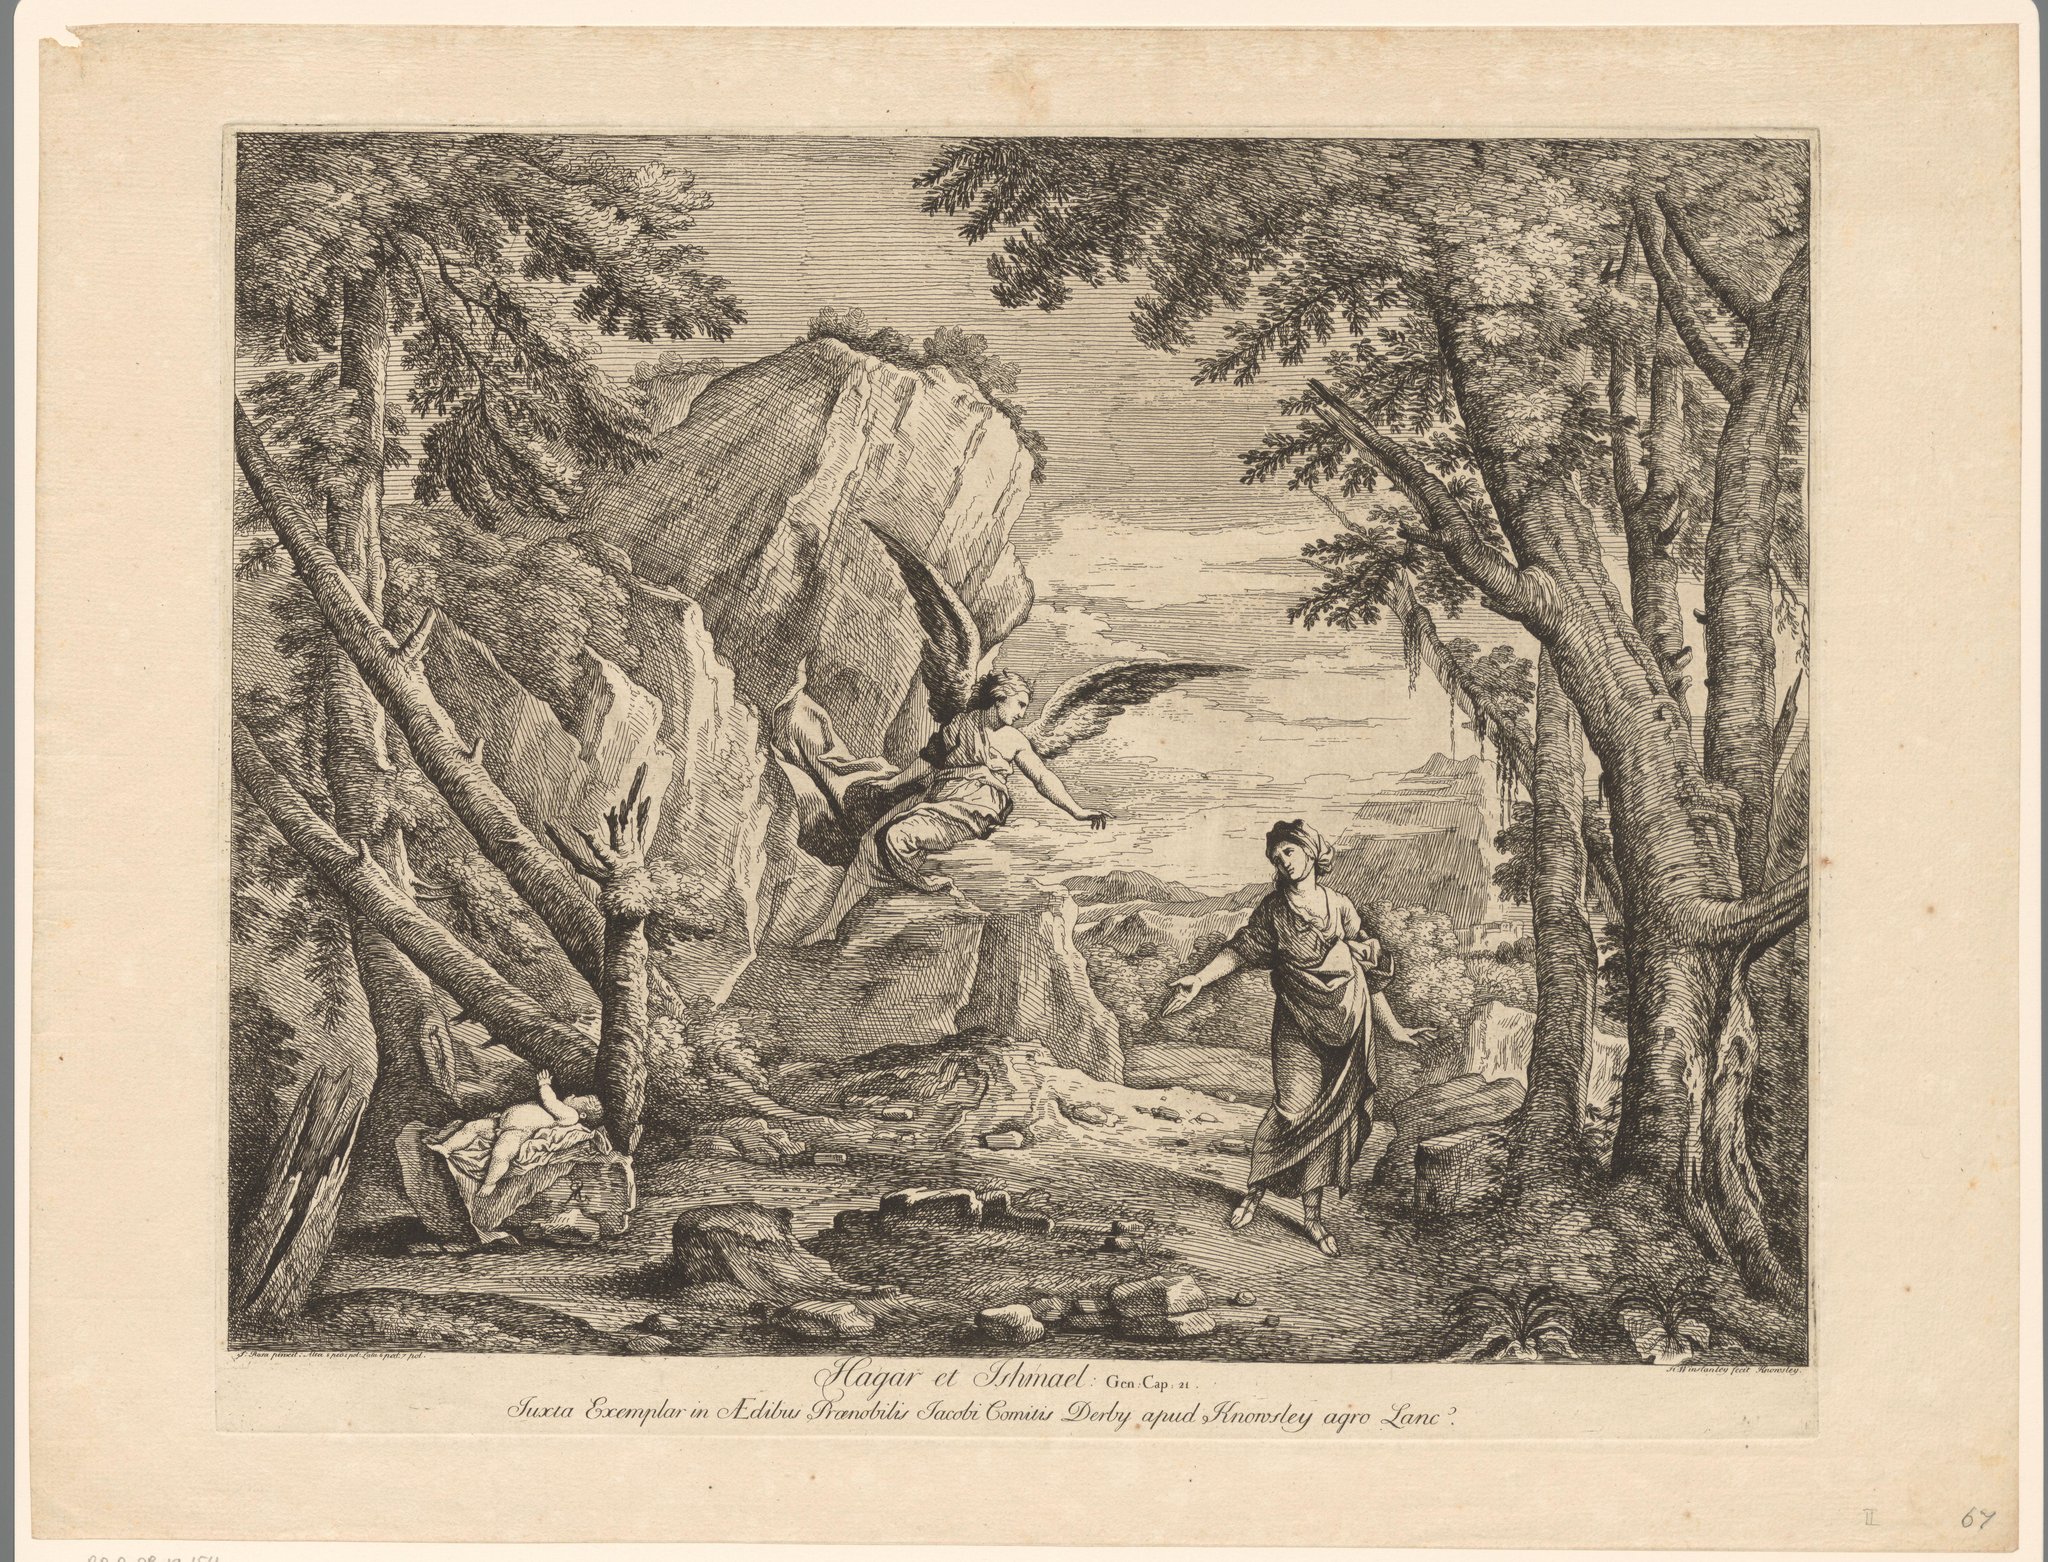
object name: print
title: Schilderijen uit de collectie Knowsley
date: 1728-1729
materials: paper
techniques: etching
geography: knowsley hall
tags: an angel appears and reveals a well of water to hagar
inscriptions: collector's mark: Lugt 240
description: Links ligt Ismaël op een rots onder een boom.